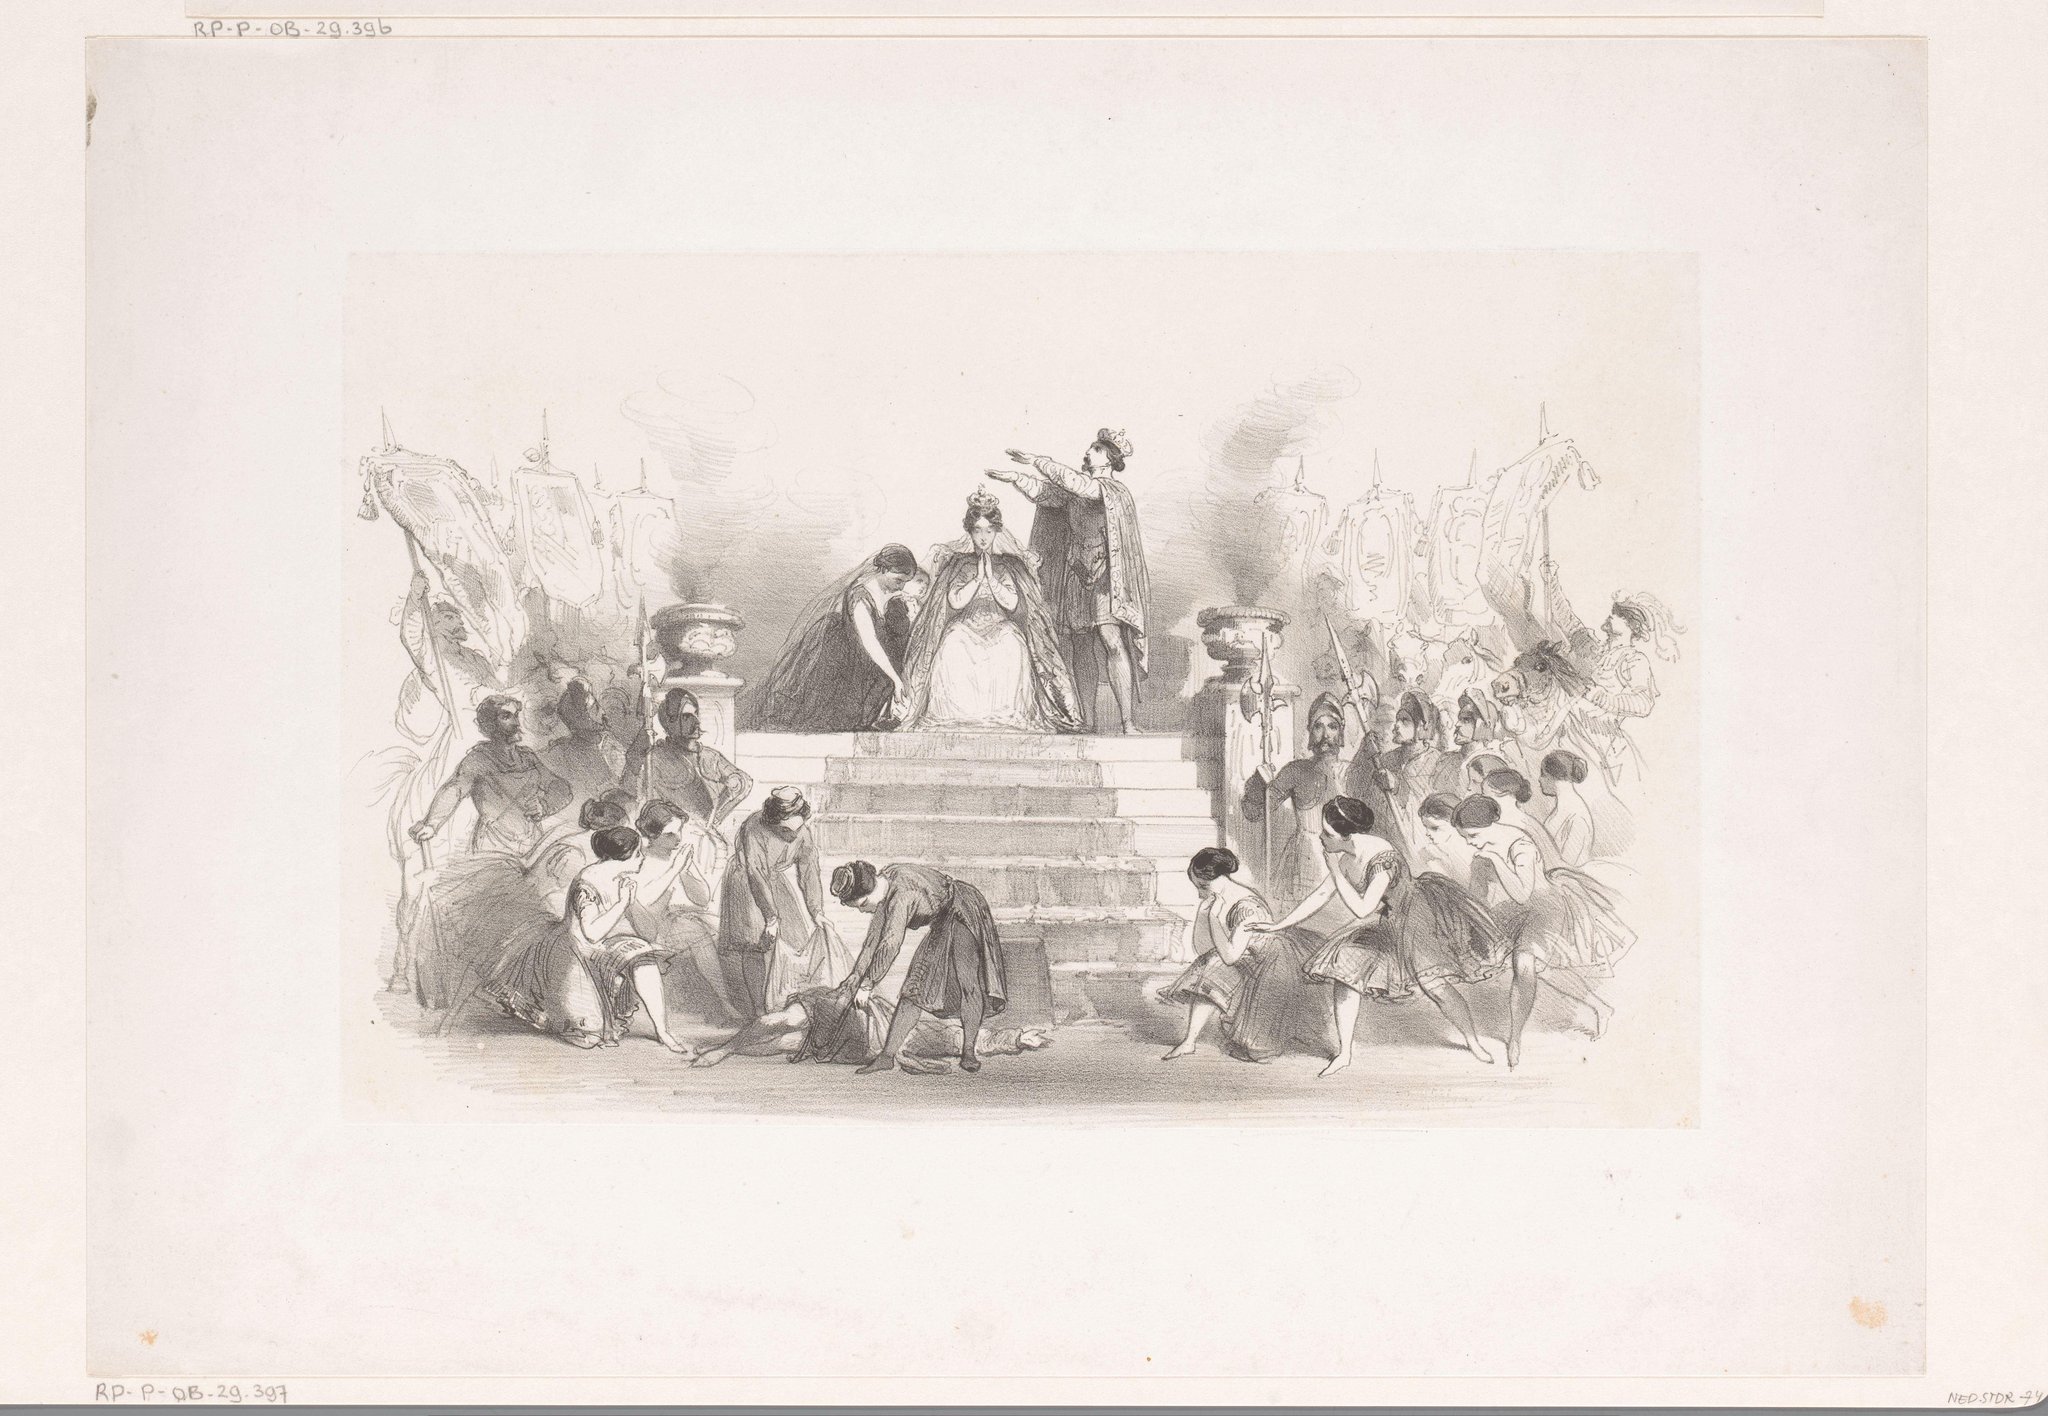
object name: print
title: Kroning van Inês de Castro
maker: charles rochussen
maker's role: draughtsman, painter, print maker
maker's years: 1814-1894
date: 1824-1894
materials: paper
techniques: tone lithography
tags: coronation of a ruler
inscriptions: collector's mark: Lugt 2228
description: Scène uit een toneelstuk over het leven van Inês de Castro, minnares van Peter van Portugal. Inês wordt gekroond door de koning. Rondom zitten knielende figuren.